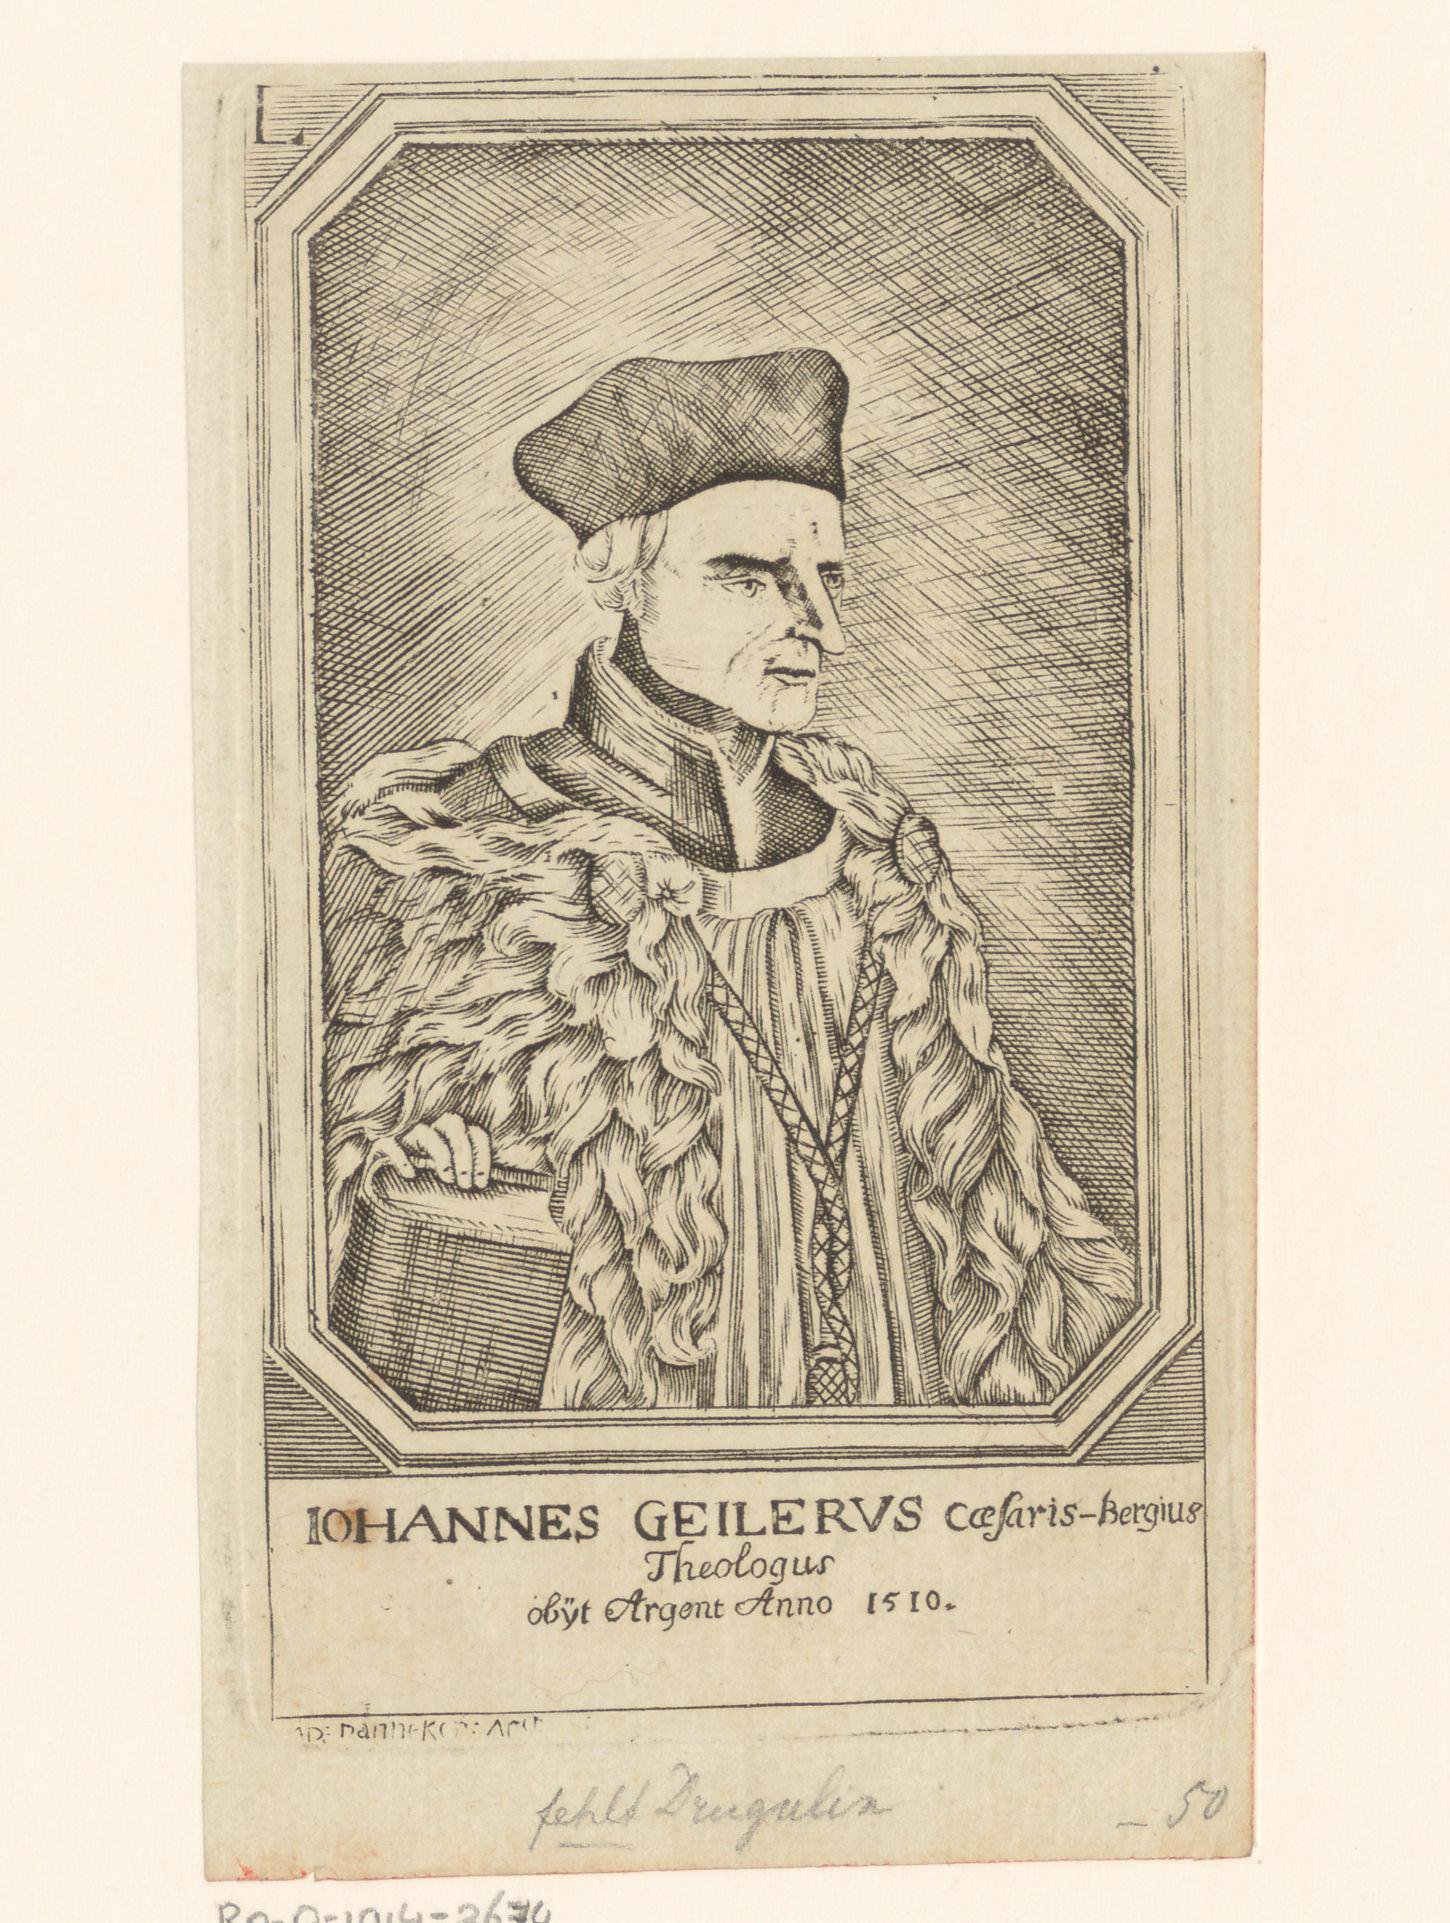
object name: print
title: Portret van Johannes Geiler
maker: a.d. dannegger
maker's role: print maker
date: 1685-1707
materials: paper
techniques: engraving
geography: straatsburg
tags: coat, historical persons, book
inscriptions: collector's mark: Lugt 2228